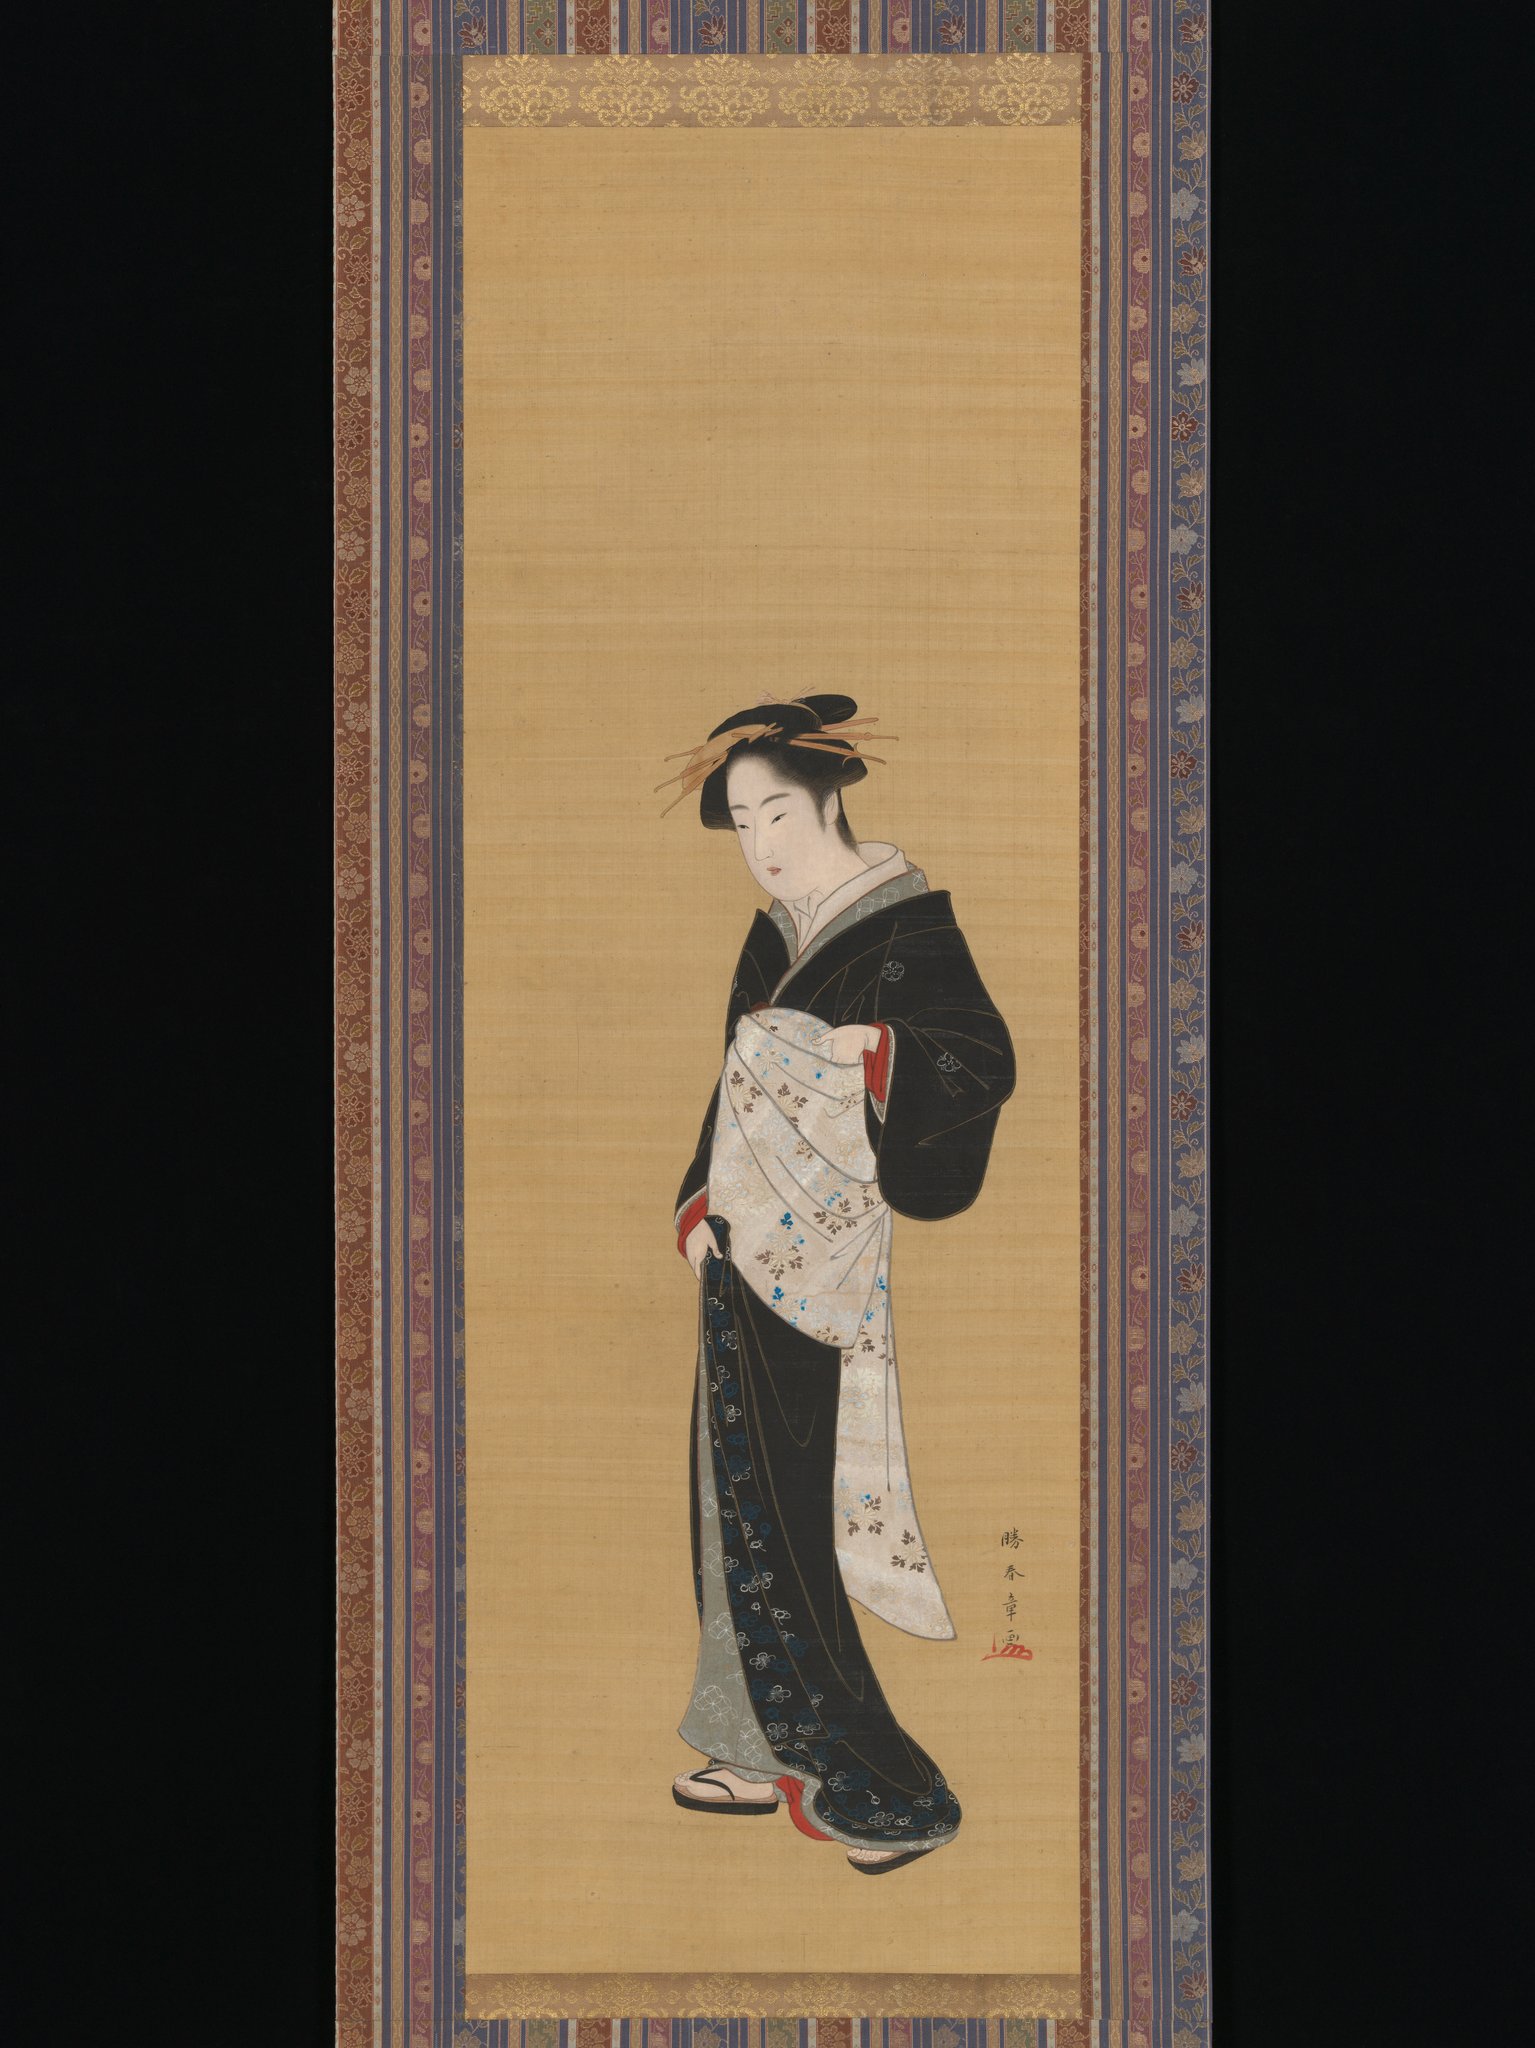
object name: hanging scroll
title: Woman in a Black Kimono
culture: japanese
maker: katsukawa shunshō 勝川春章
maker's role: artist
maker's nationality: japanese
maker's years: 1726-1792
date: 1783-1789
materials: gold, ink, silk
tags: women